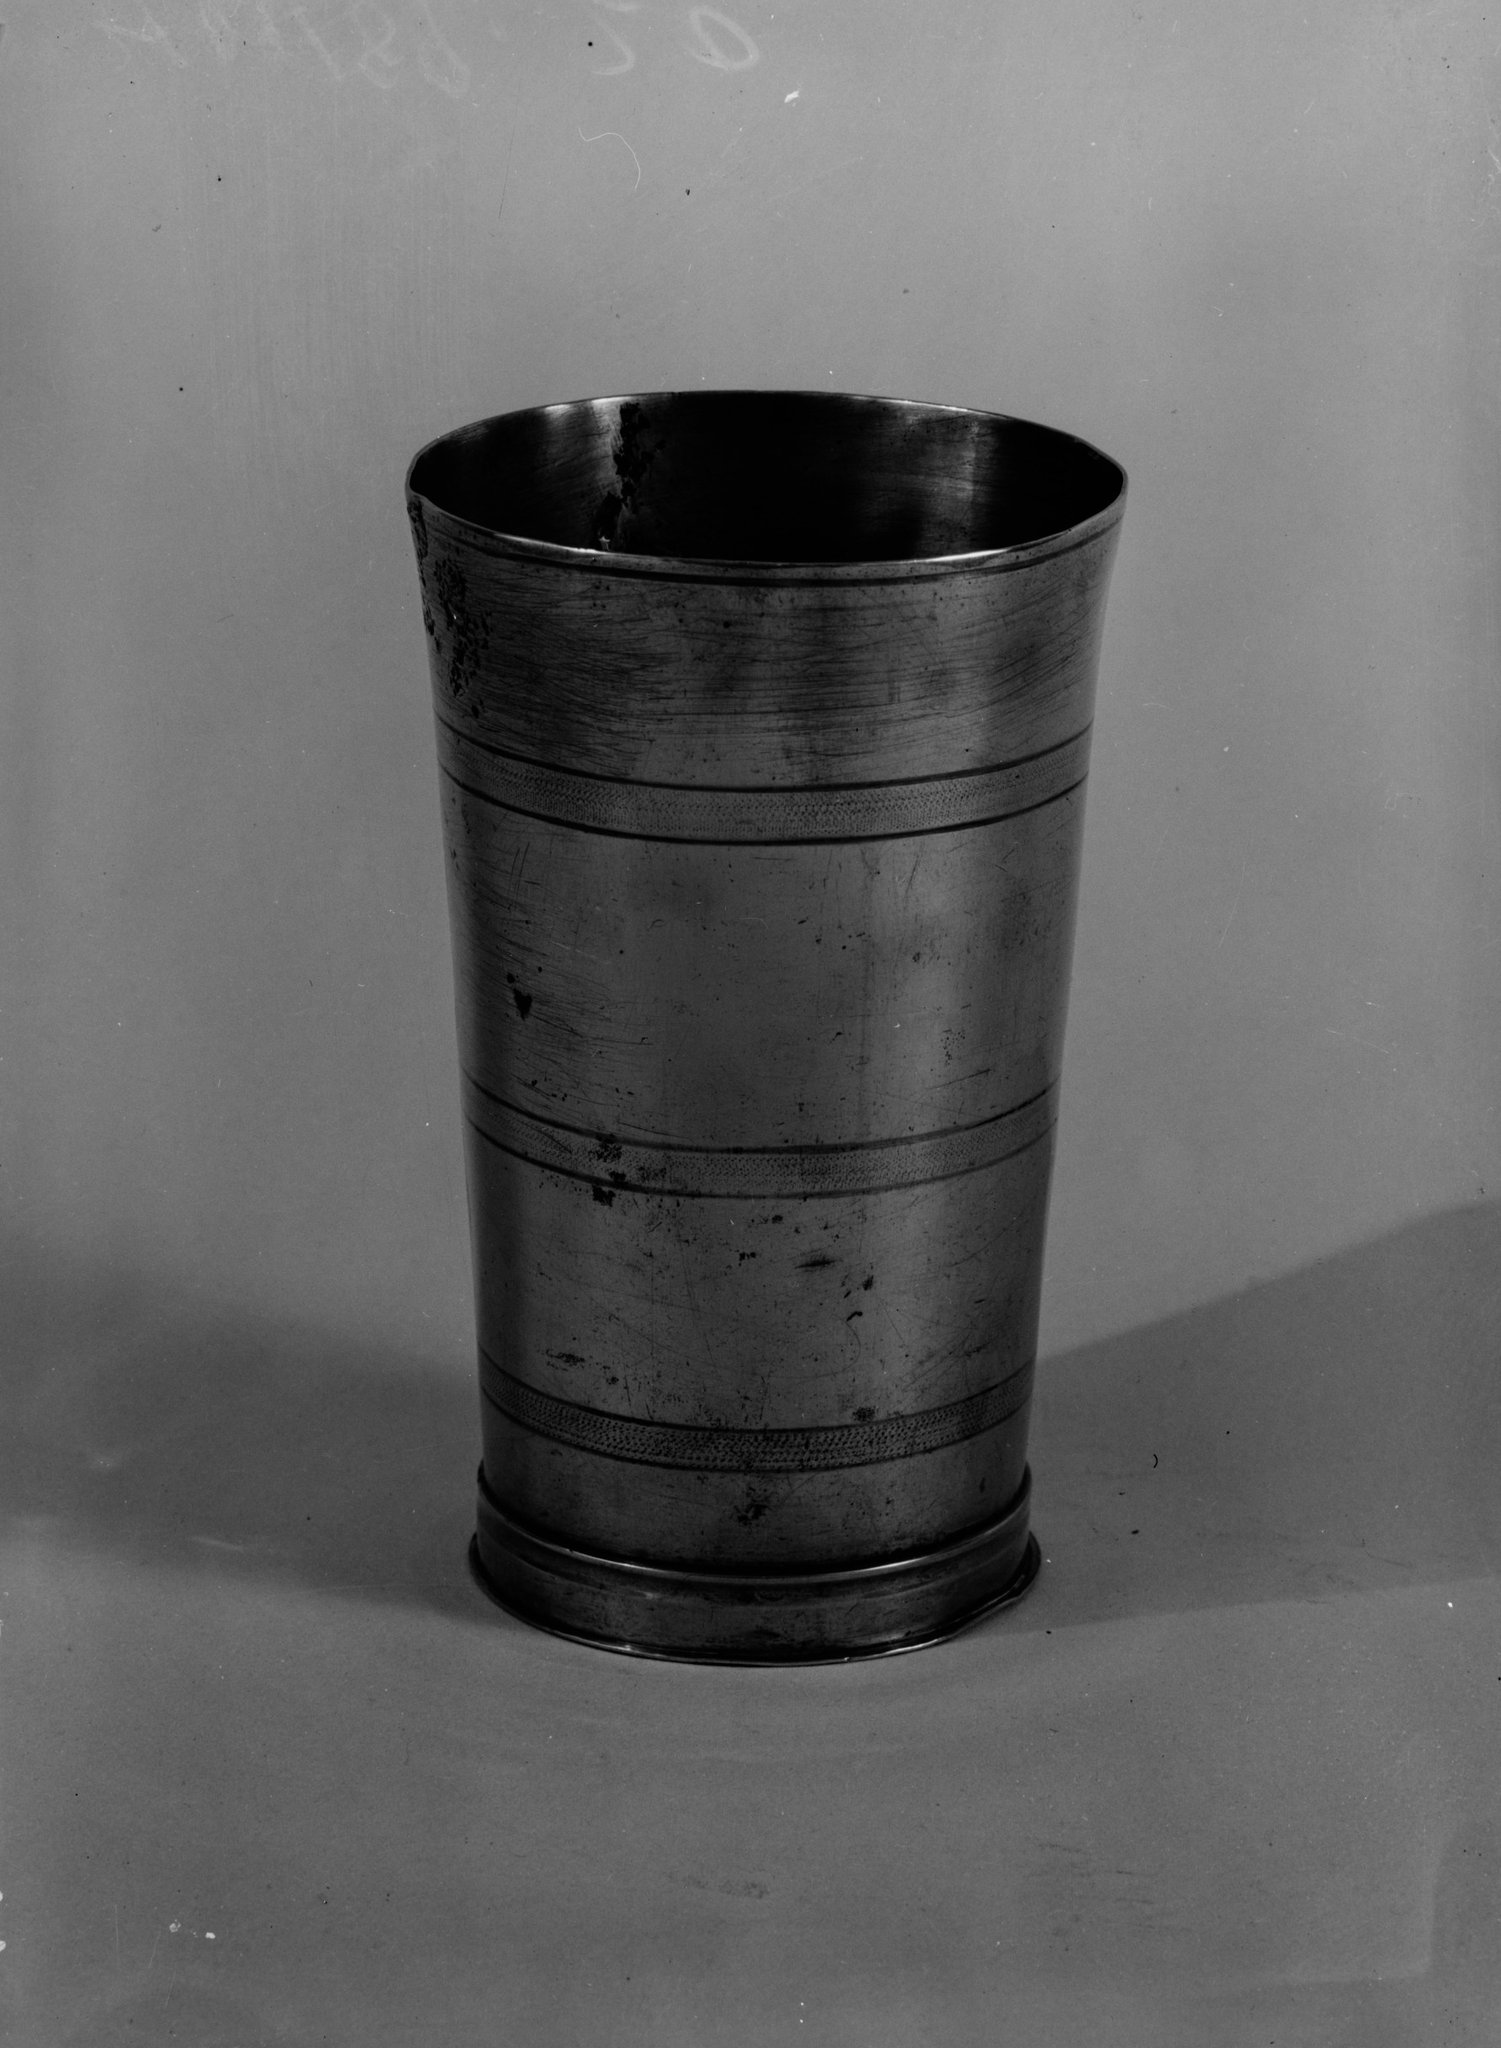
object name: beaker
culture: american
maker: oliver trask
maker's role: maker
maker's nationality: american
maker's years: 1792-1847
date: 1832-1839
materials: pewter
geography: united states